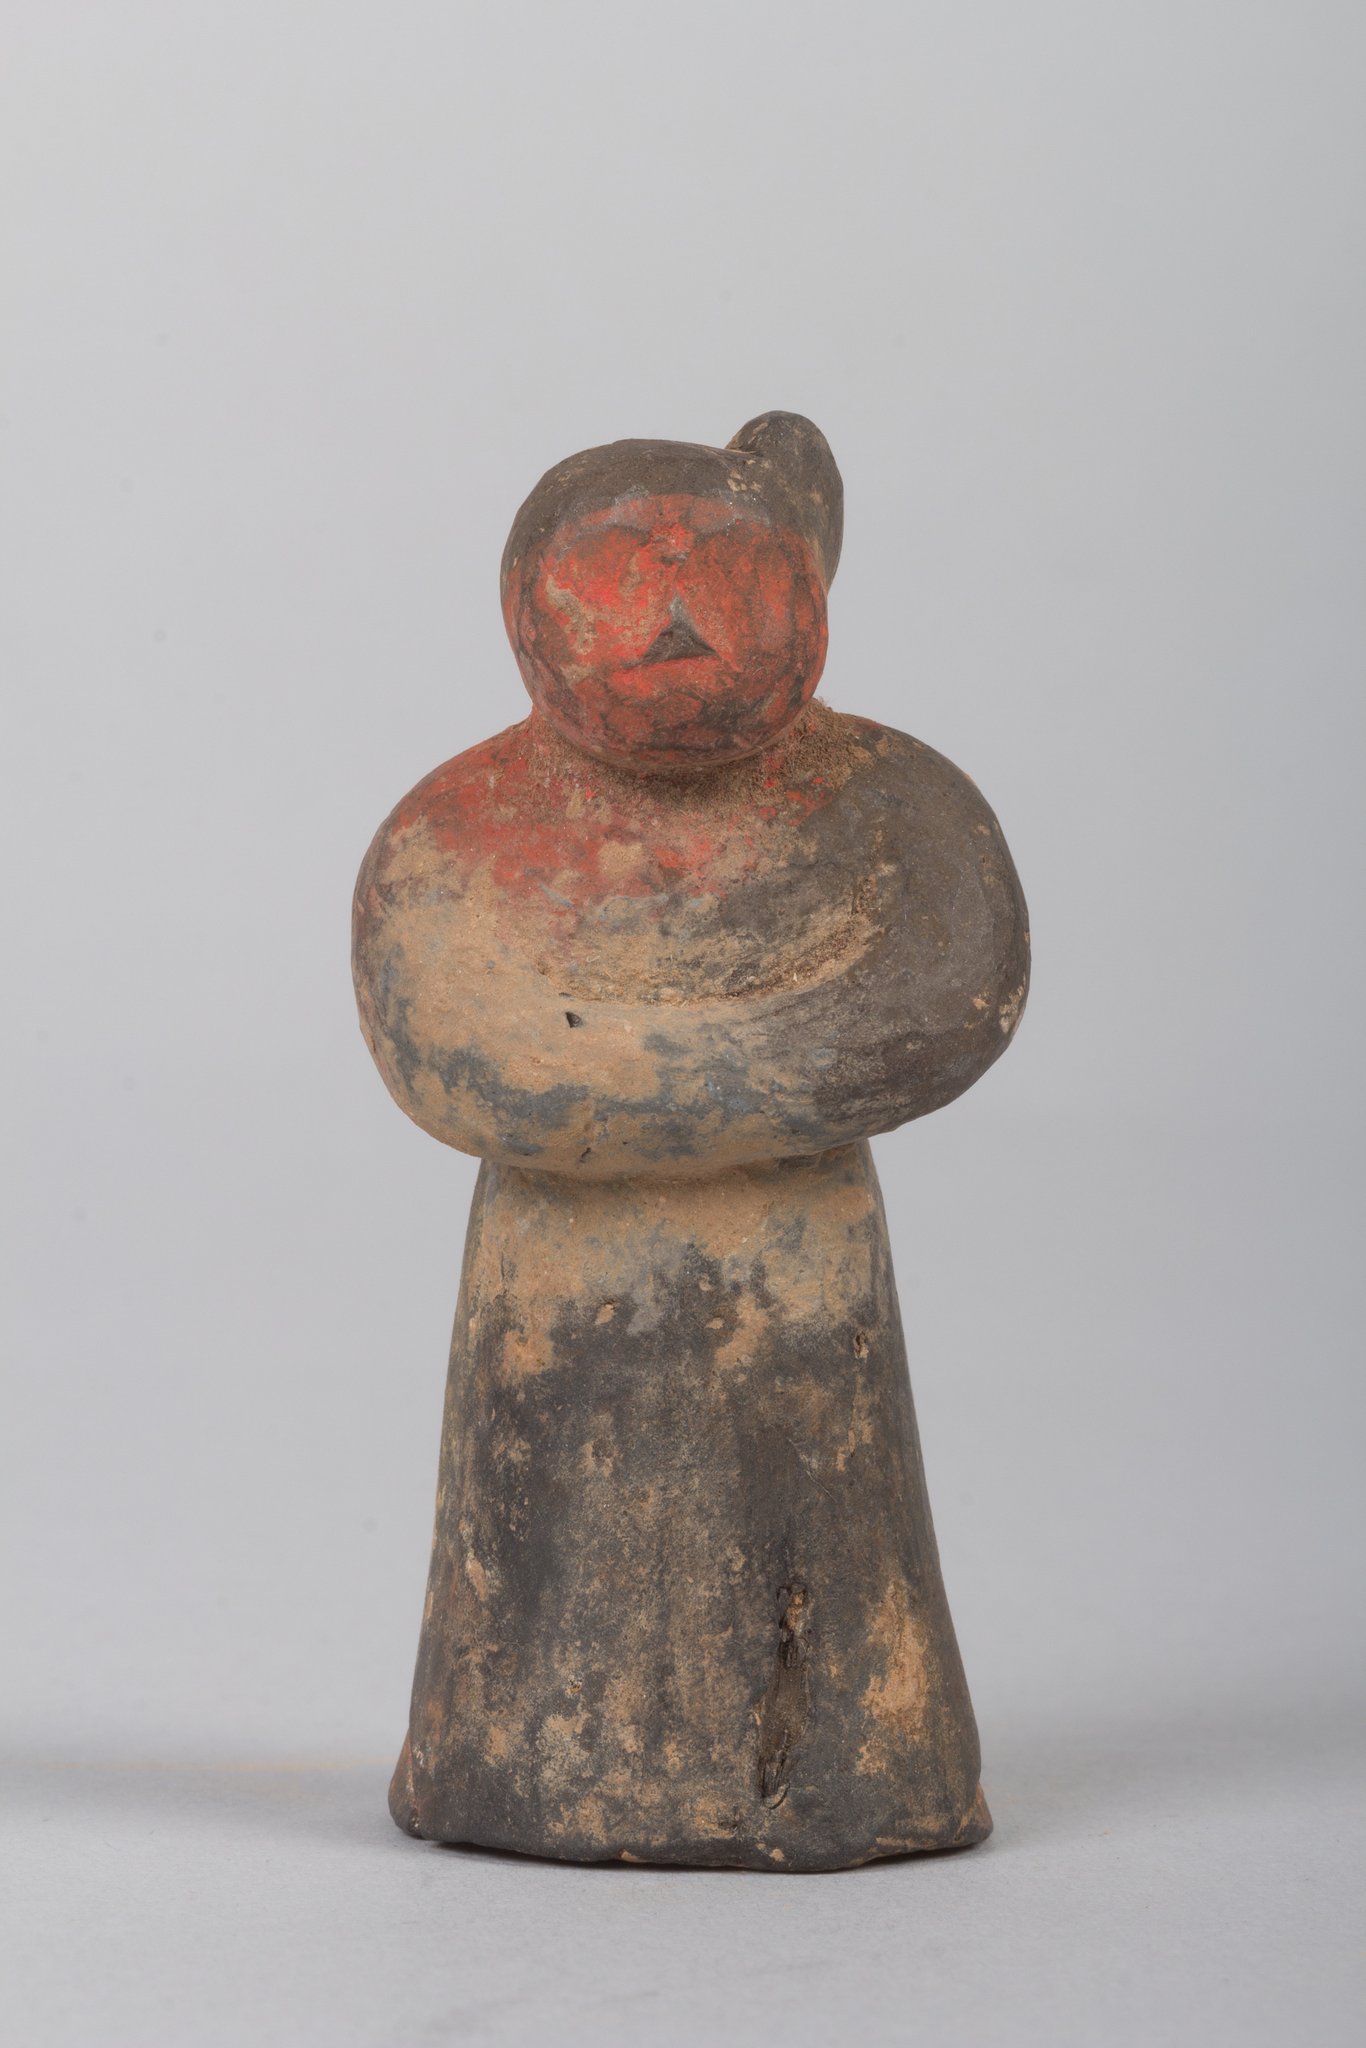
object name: figure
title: Figure of a woman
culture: chinese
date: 400-201 BCE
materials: clay